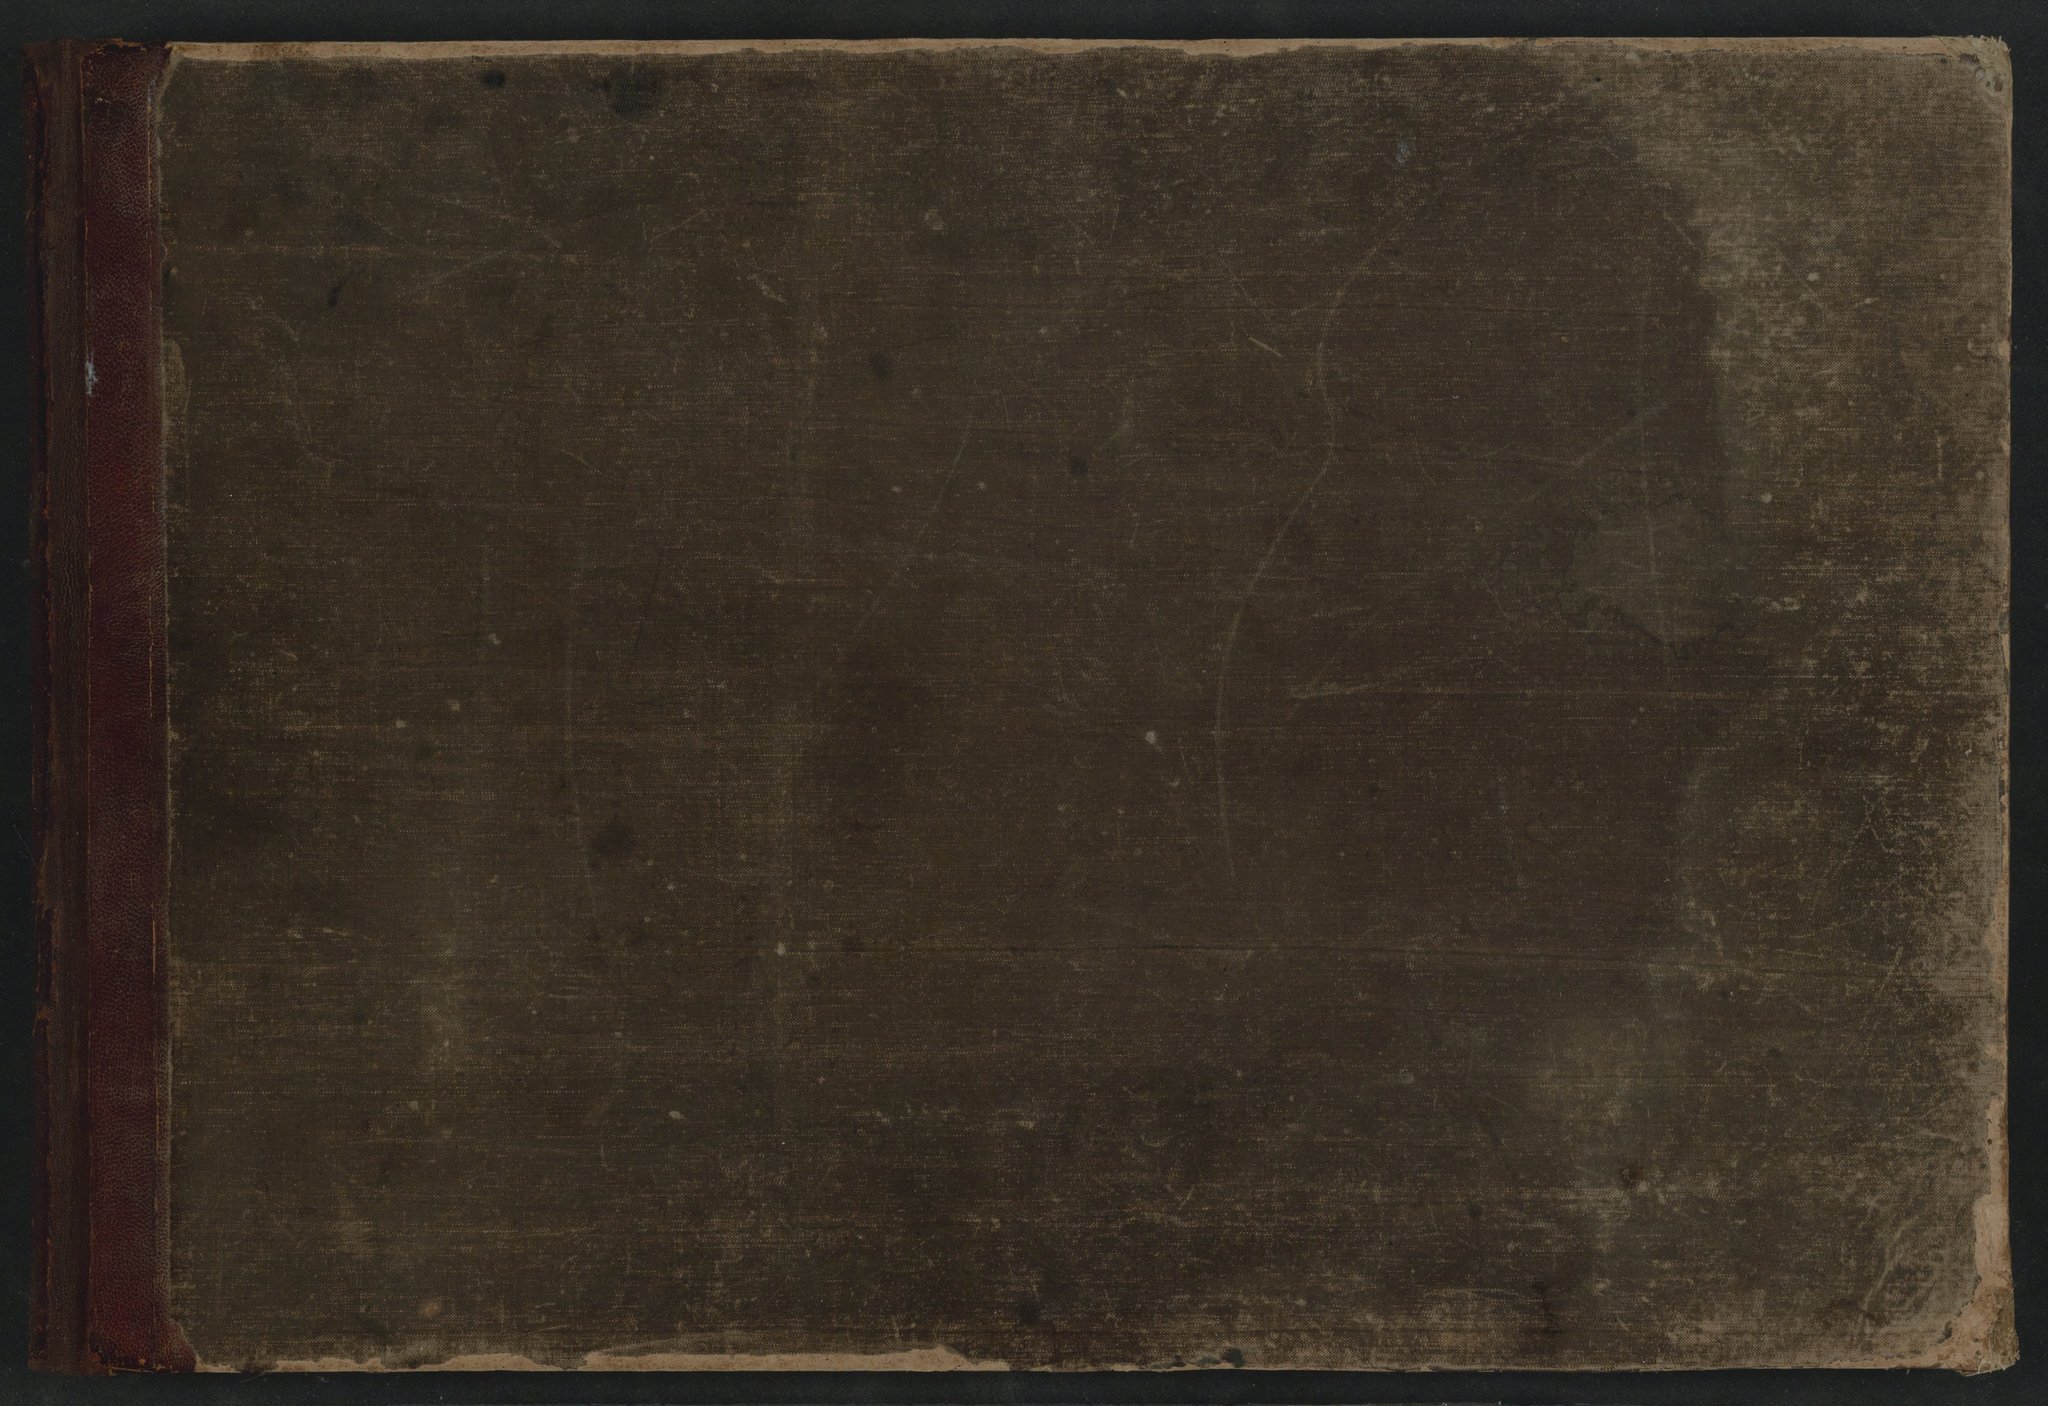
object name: sketchbook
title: Schetsboek met 68 bladen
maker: kasparus karsen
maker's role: draughtsman, painter, print maker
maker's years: 1810-1896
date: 1820-1896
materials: cardboard, leather, linen, paper, pencil, watercolor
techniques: brush, pen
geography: czech republic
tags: river, village street, prospect of city, town panorama, silhouette of city, prague, amsterdam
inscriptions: collector's mark: Lugt 2228a, annotation: ‘Dit boek bevat drieenveertig teekeningen/ (genummer) van mijn vader./ Ed Karsen/ schetsboek van K. Karsen’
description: De tekeningen in het schetsboek zijn genummerd 1 t/m 41 en 43. Blad 42 ontbreekt. De verso van bladen 1 t/m 30 en 32 t/m 43 zijn blanco. Tussen blad 32 en 33, 35 en 36 en 41 en 43 zit een blanco ongenummerd blad. Na blad 43 is het schetsboek blanco.